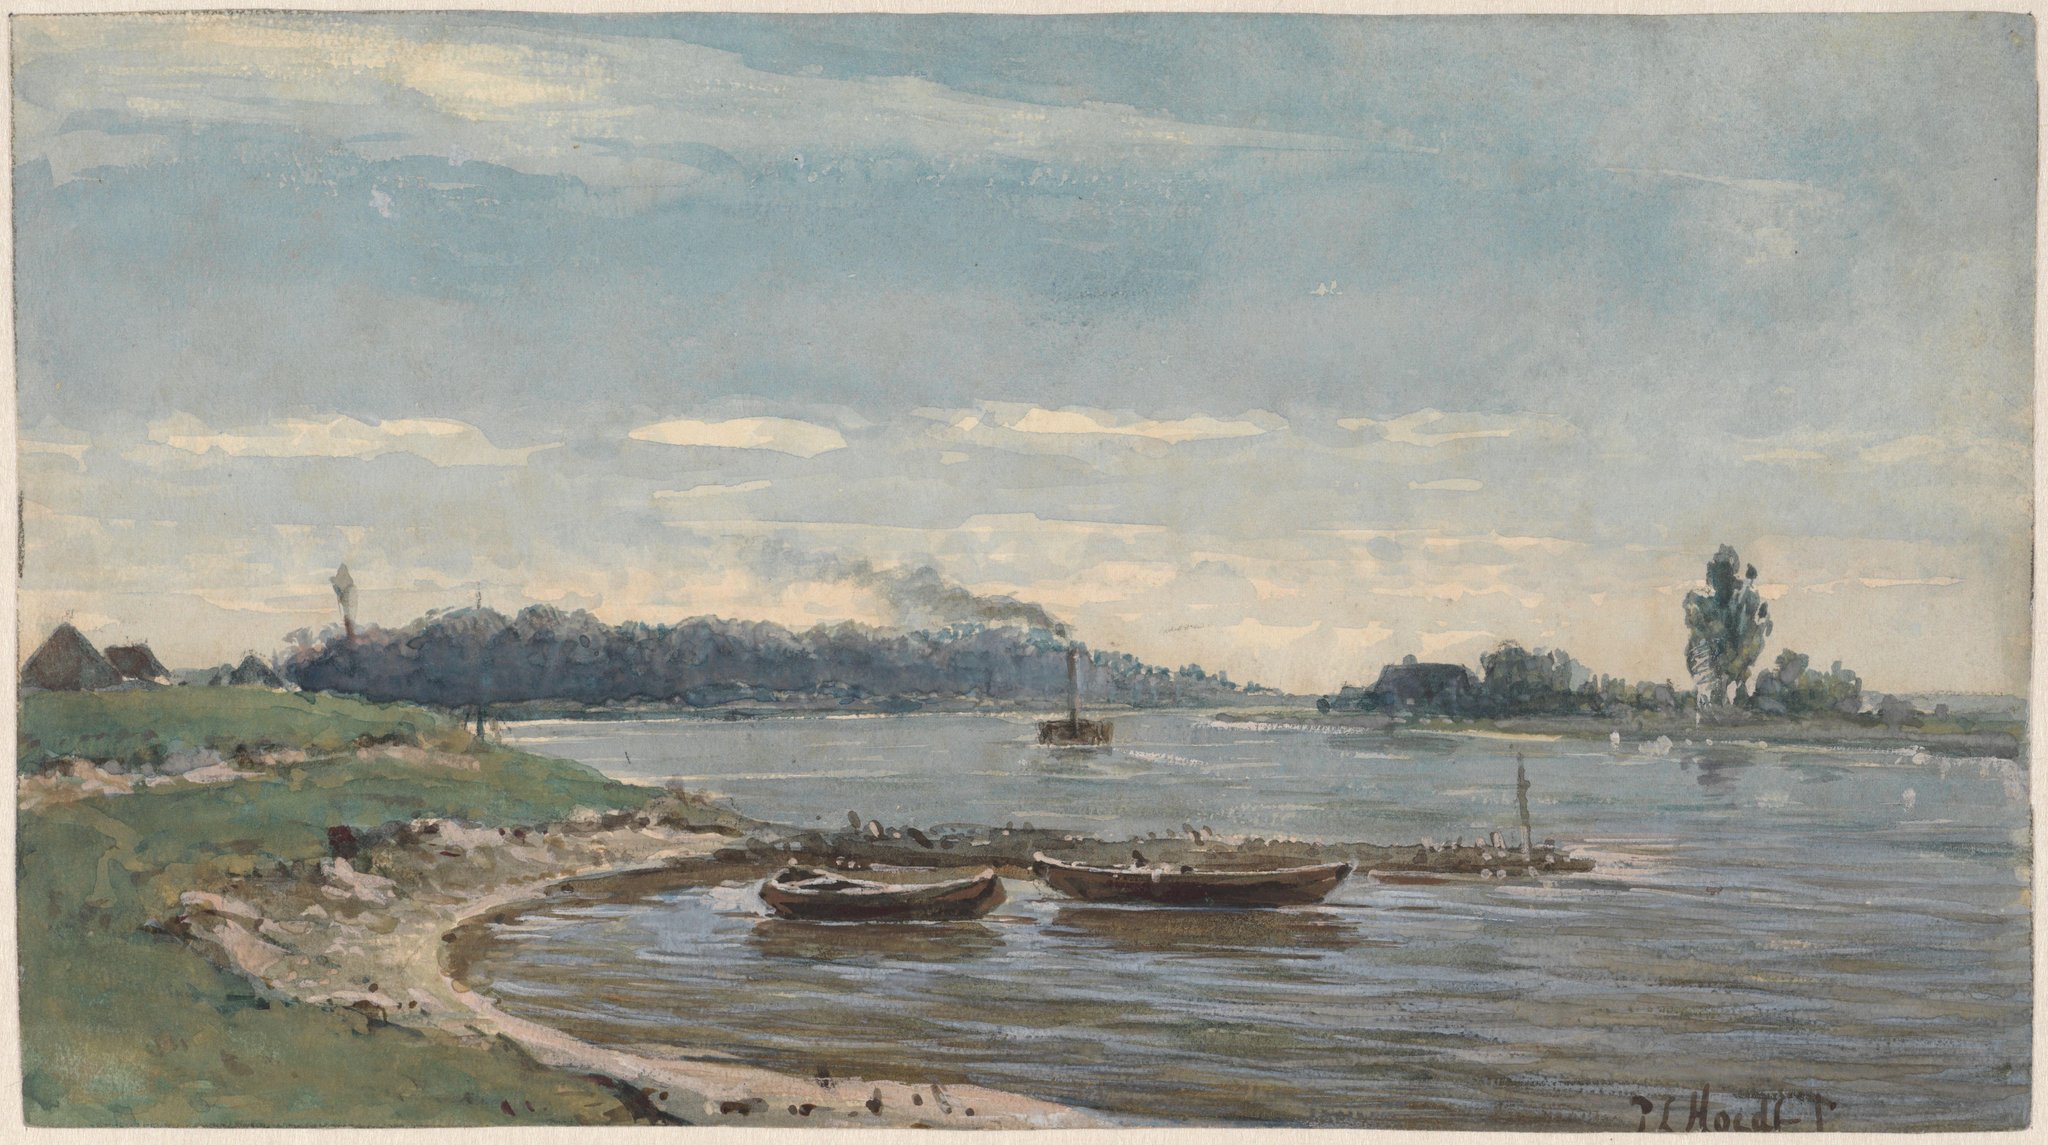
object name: drawing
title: Hollands riviergezicht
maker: pieter louis hoedt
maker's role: draughtsman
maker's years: 1832-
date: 1847-1893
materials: chalk, paper, watercolor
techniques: brush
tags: river